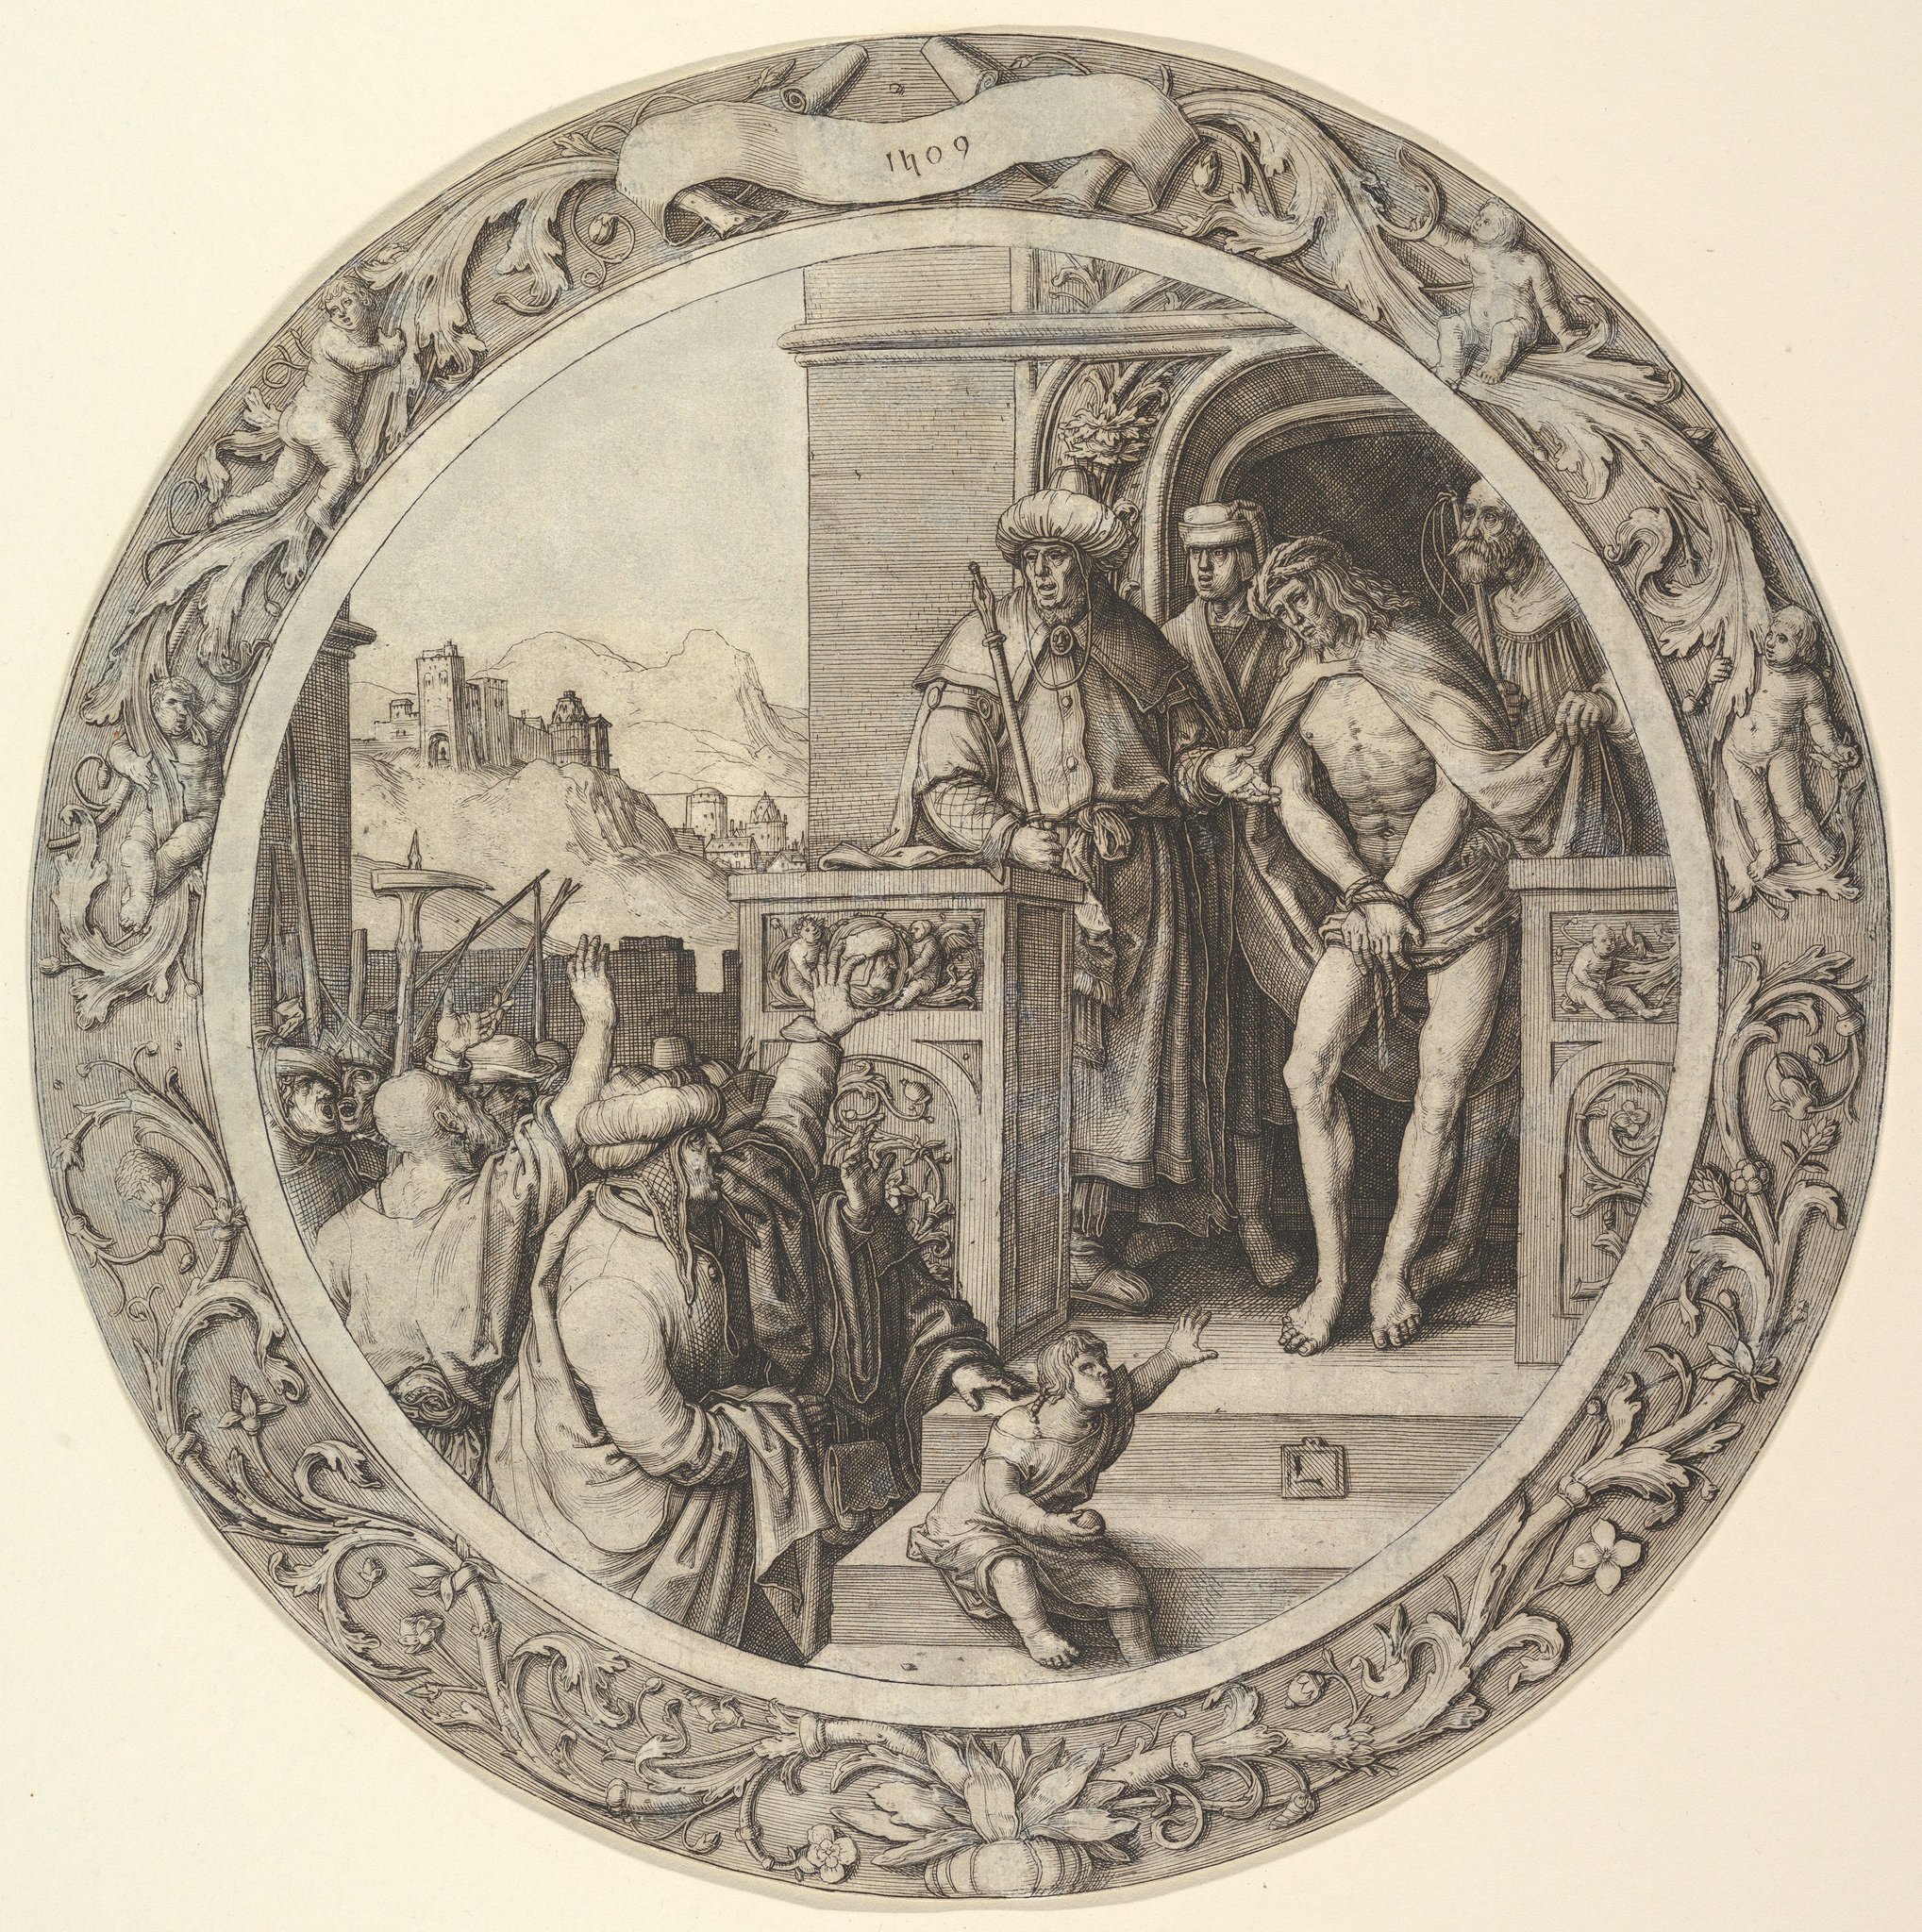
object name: print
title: Ecce Homo, from the Circular Passion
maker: lucas van leyden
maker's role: artist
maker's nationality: netherlandish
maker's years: 1494-1533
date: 1509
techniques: engraving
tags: men,christ